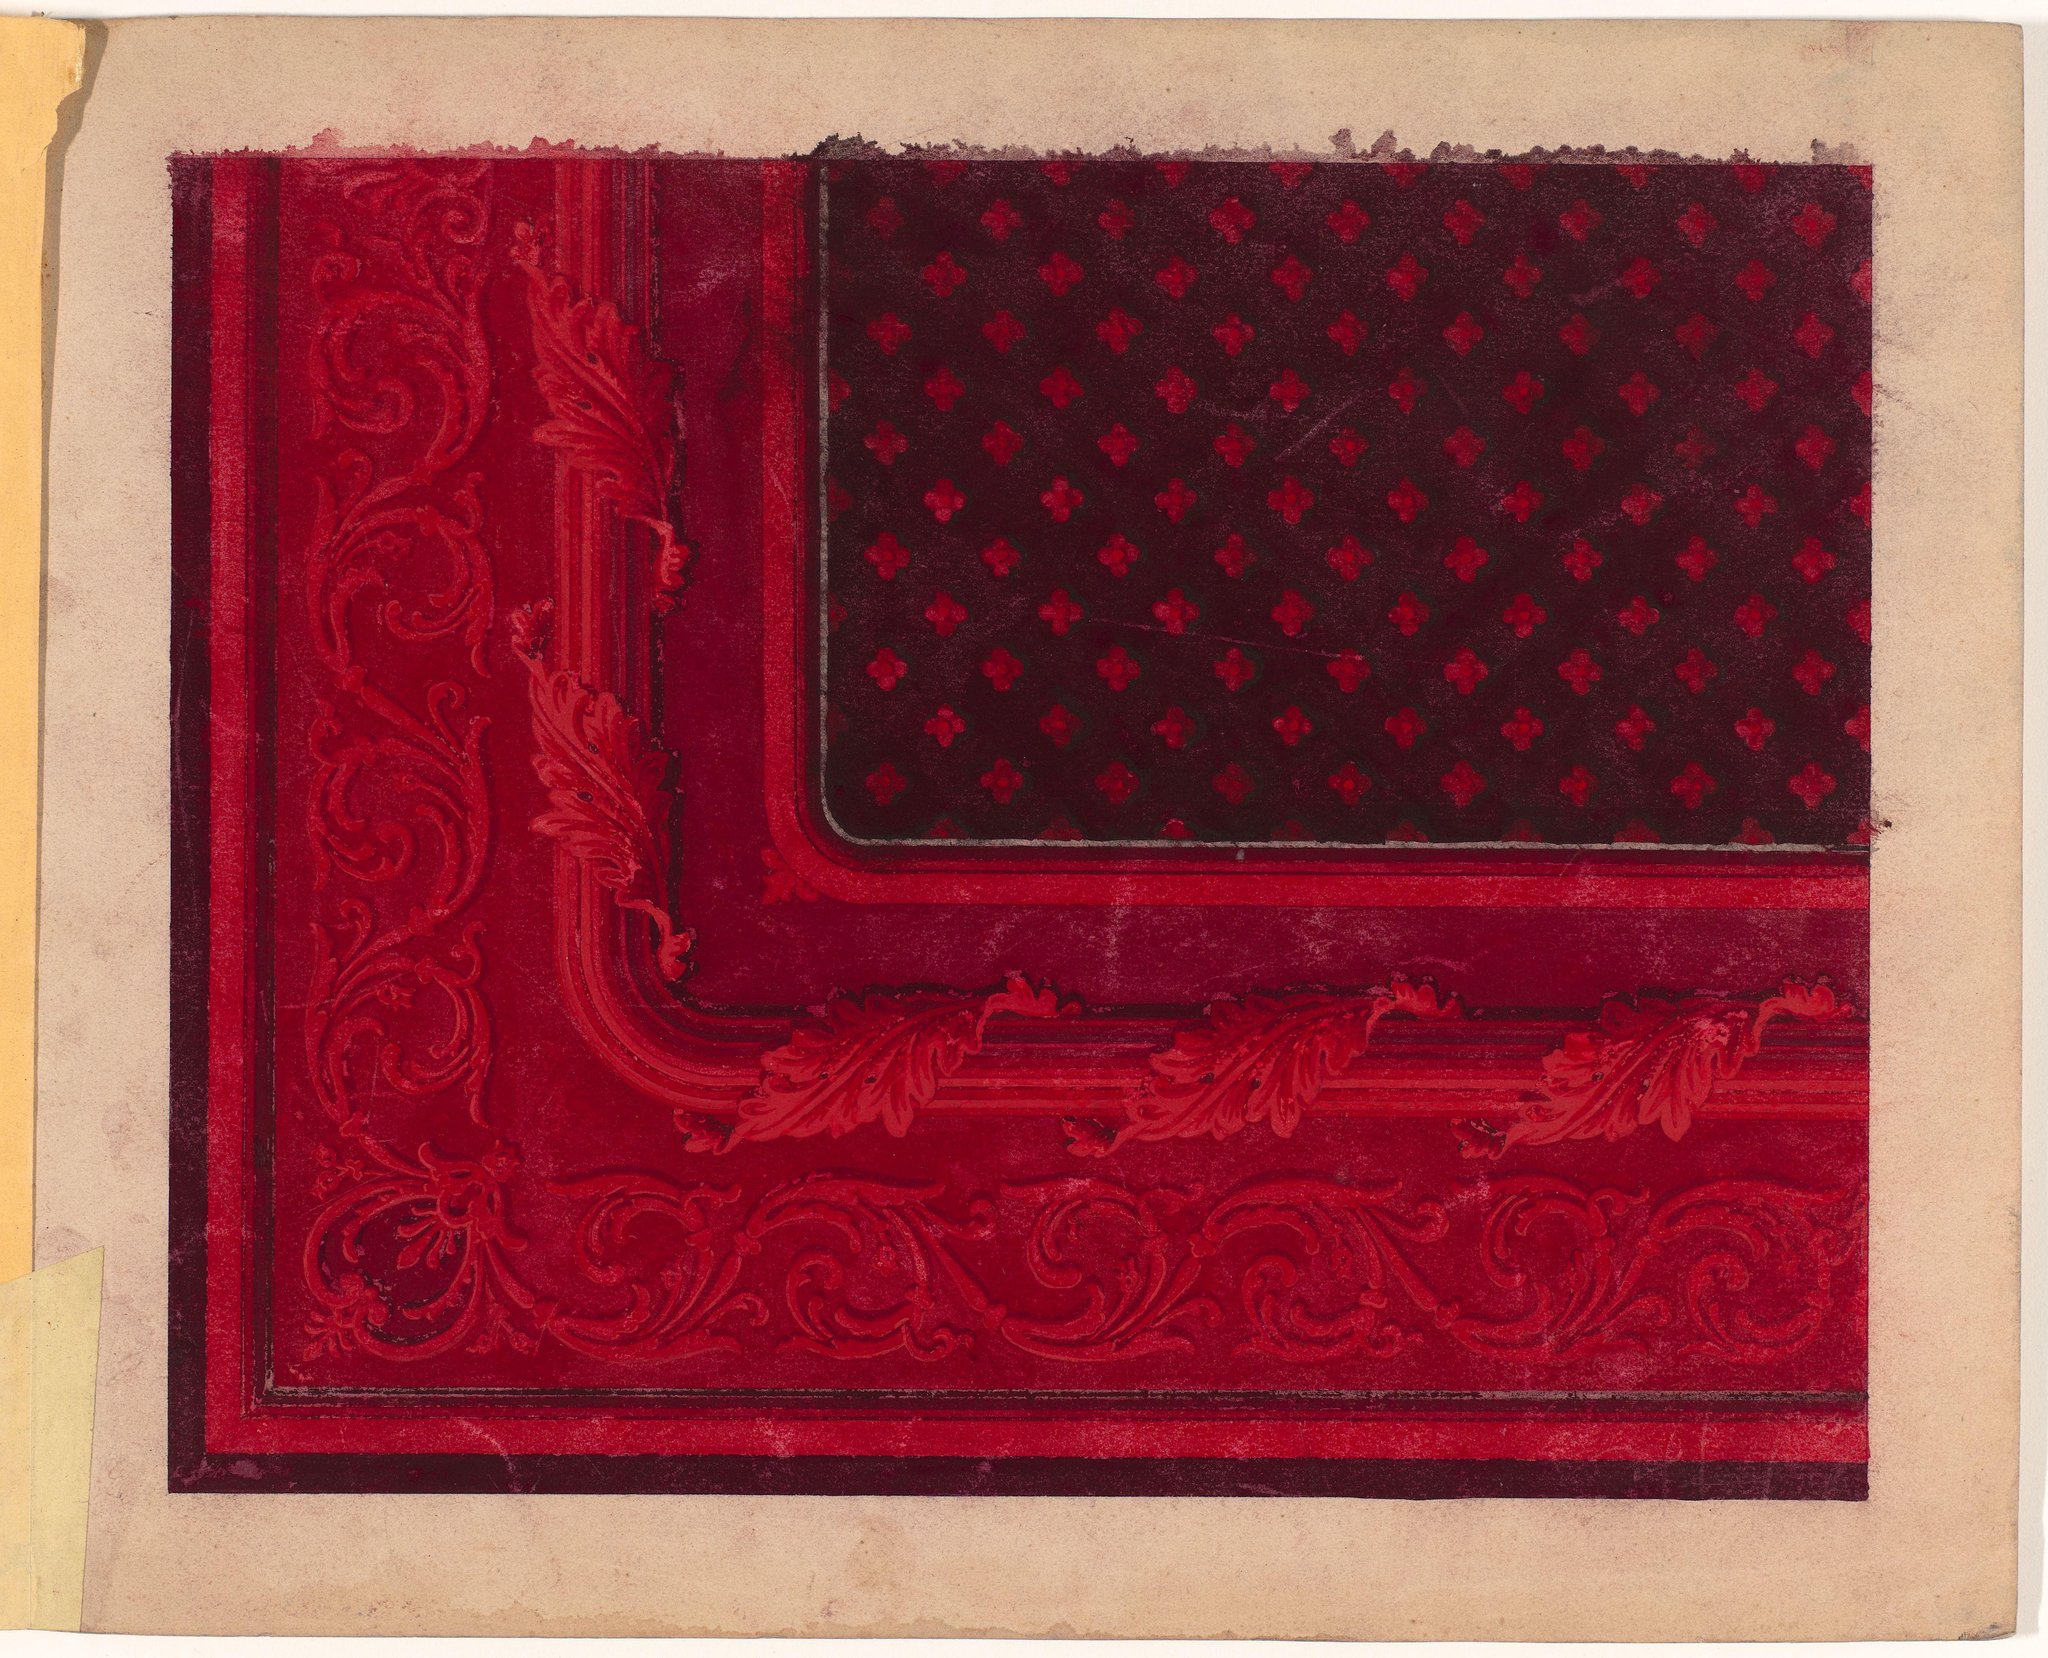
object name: design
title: Ontwerp voor een tapijt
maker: Anonymous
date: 1854-1864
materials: gouache, paper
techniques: brush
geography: amsterdam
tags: ornaments ~ art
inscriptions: stamp: ‘Koninklyke Tapytfabriek Firma P. van Calcar & Co’, number: ‘No 71.ii.B.’, retailer's mark: ‘JHS.’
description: De presentatietekeningen BK-1971-77-1 t/m 86 zijn kopieën van de originele ontwerptekeningen. Ze werden gemaakt voor vertegenwoordigers van bijvoorbeeld magazijnen, die ze aan hun klanten konden tonen. De meeste tekeningen tonen een kwart van het dessin inclusief rand, middenpartij (de zogenaamde grond of fond) en centraal medaillon. Door het gebruik van spiegels kan de illusie van het gehele tapijt worden opgeroepen. Een deel van de tekeningen heeft een alfabetische opeenvolgende letter als kenmerk, de andere groep een cijfer.Waarschijnlijk is de reeks dessins met een letter eerder samengesteld dan de genummerde tekeningen.